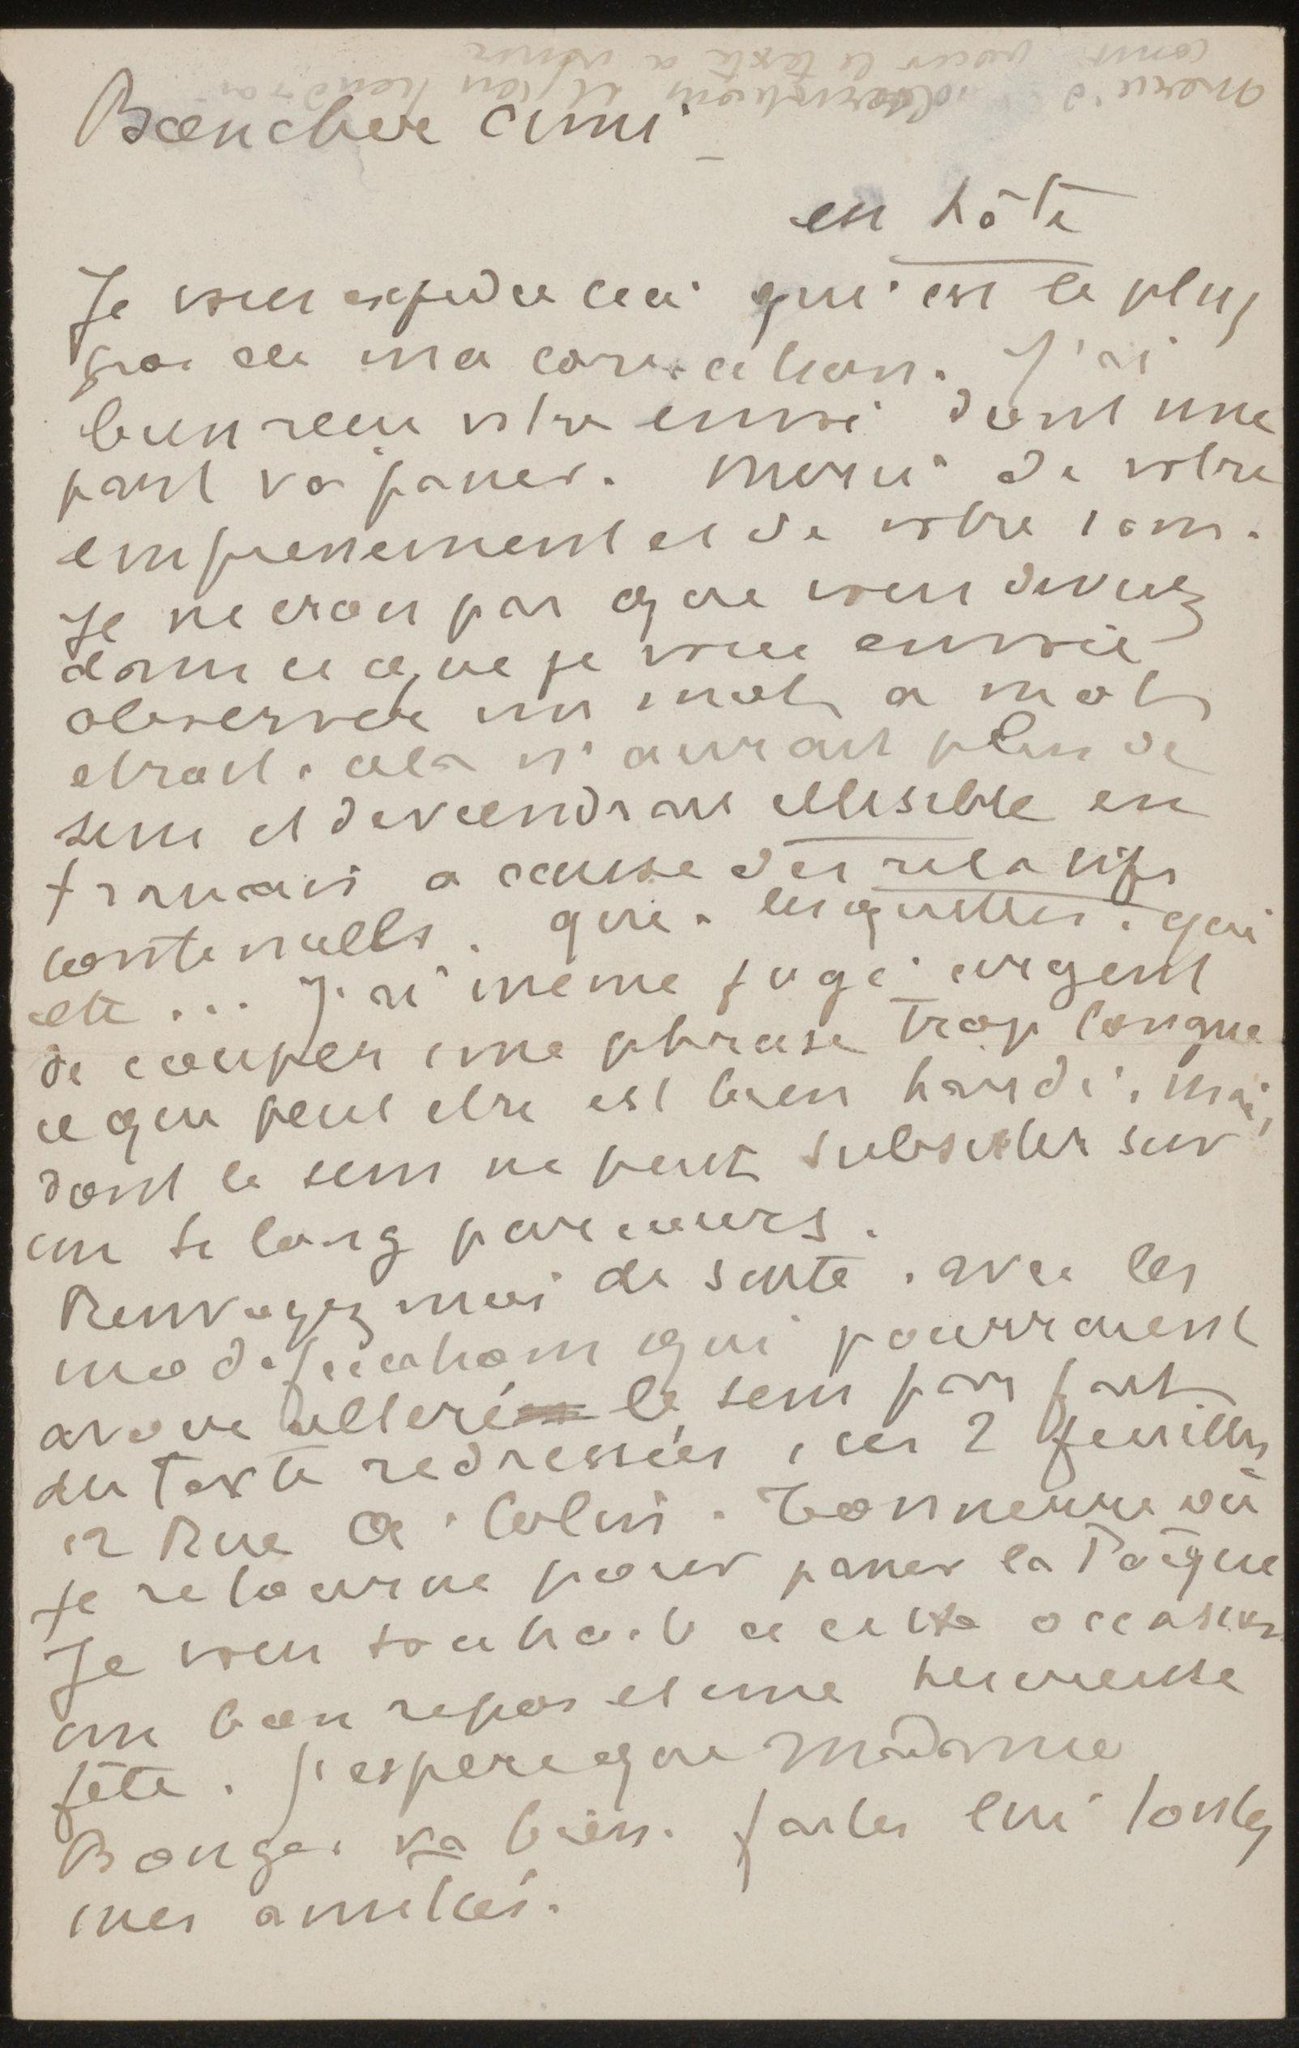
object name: letter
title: Brief aan Andries Bonger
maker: émile bernard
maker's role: print maker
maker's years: 1868-1941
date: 1878-1936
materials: ink, paper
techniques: pen, writing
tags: paris, odilon redon, painter, print maker, draughtsman, vincent van gogh, paul cézanne, amsterdam, andries bonger, art trade, art shop, applied arts, arts and crafts; industrial design, painting (including book-illumination, miniature-painting), money